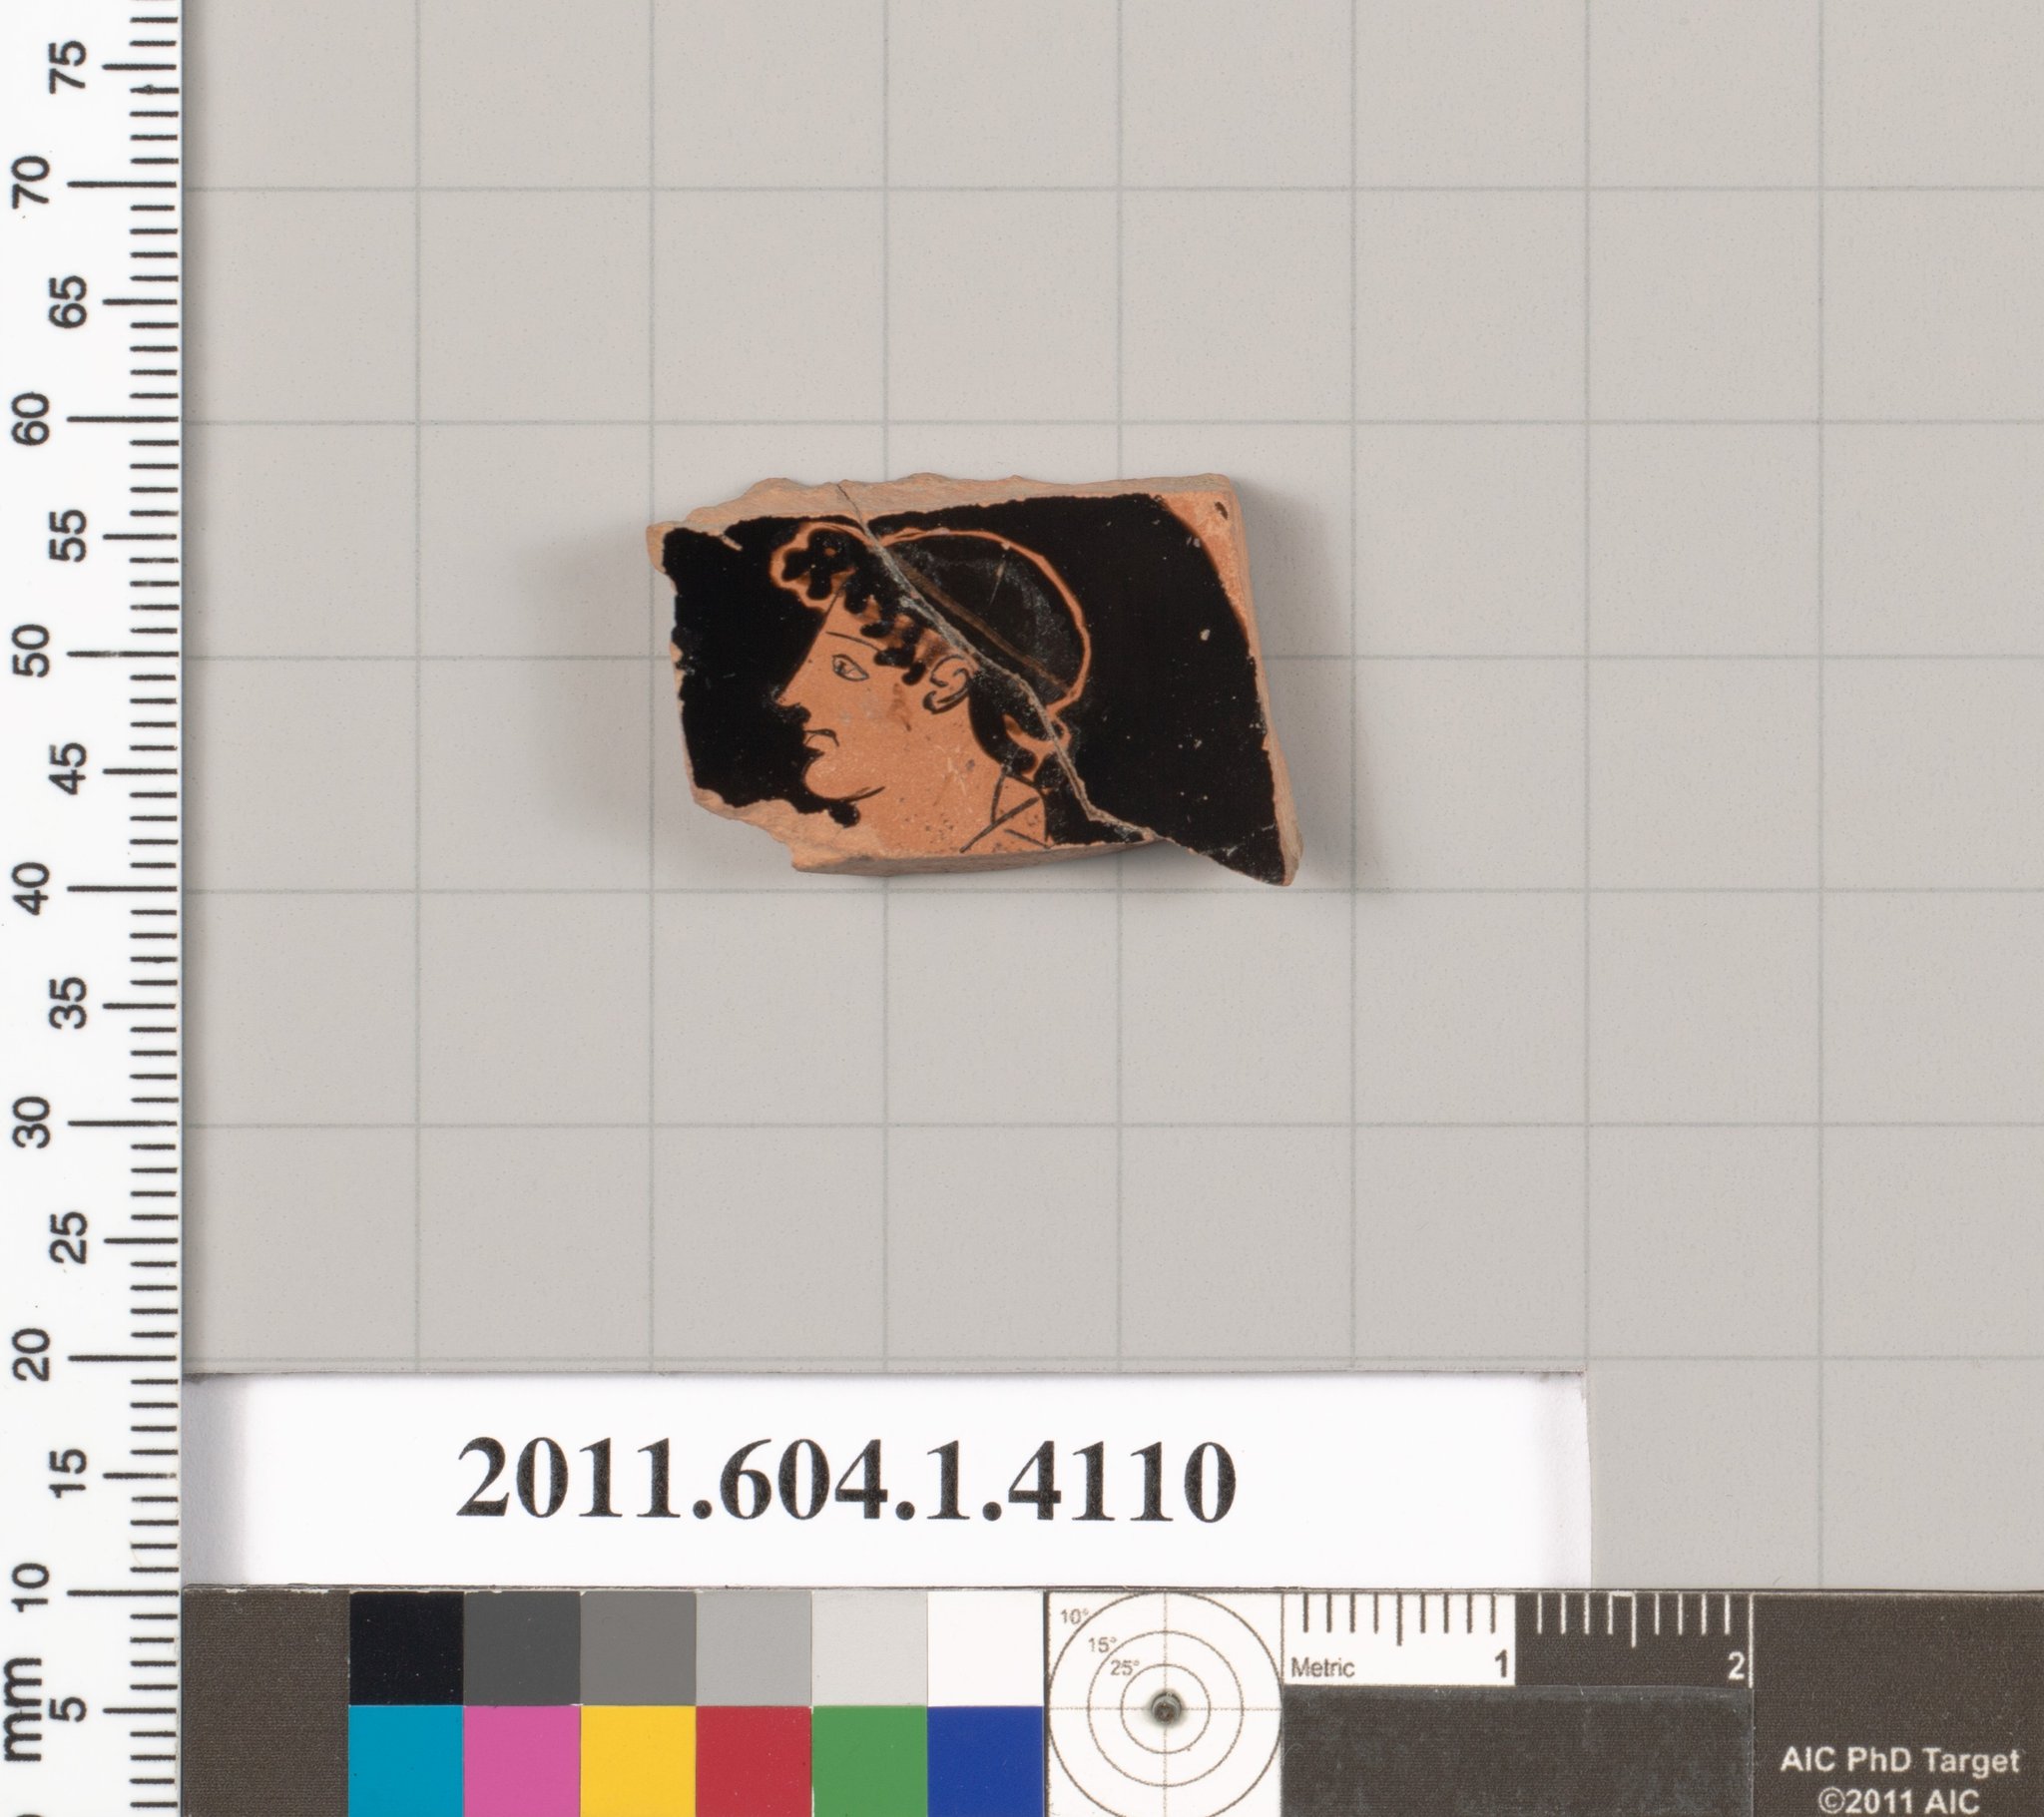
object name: kylix fragment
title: Terracotta fragment of a kylix (drinking cup)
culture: greek, attic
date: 475-451 BCE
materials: terracotta